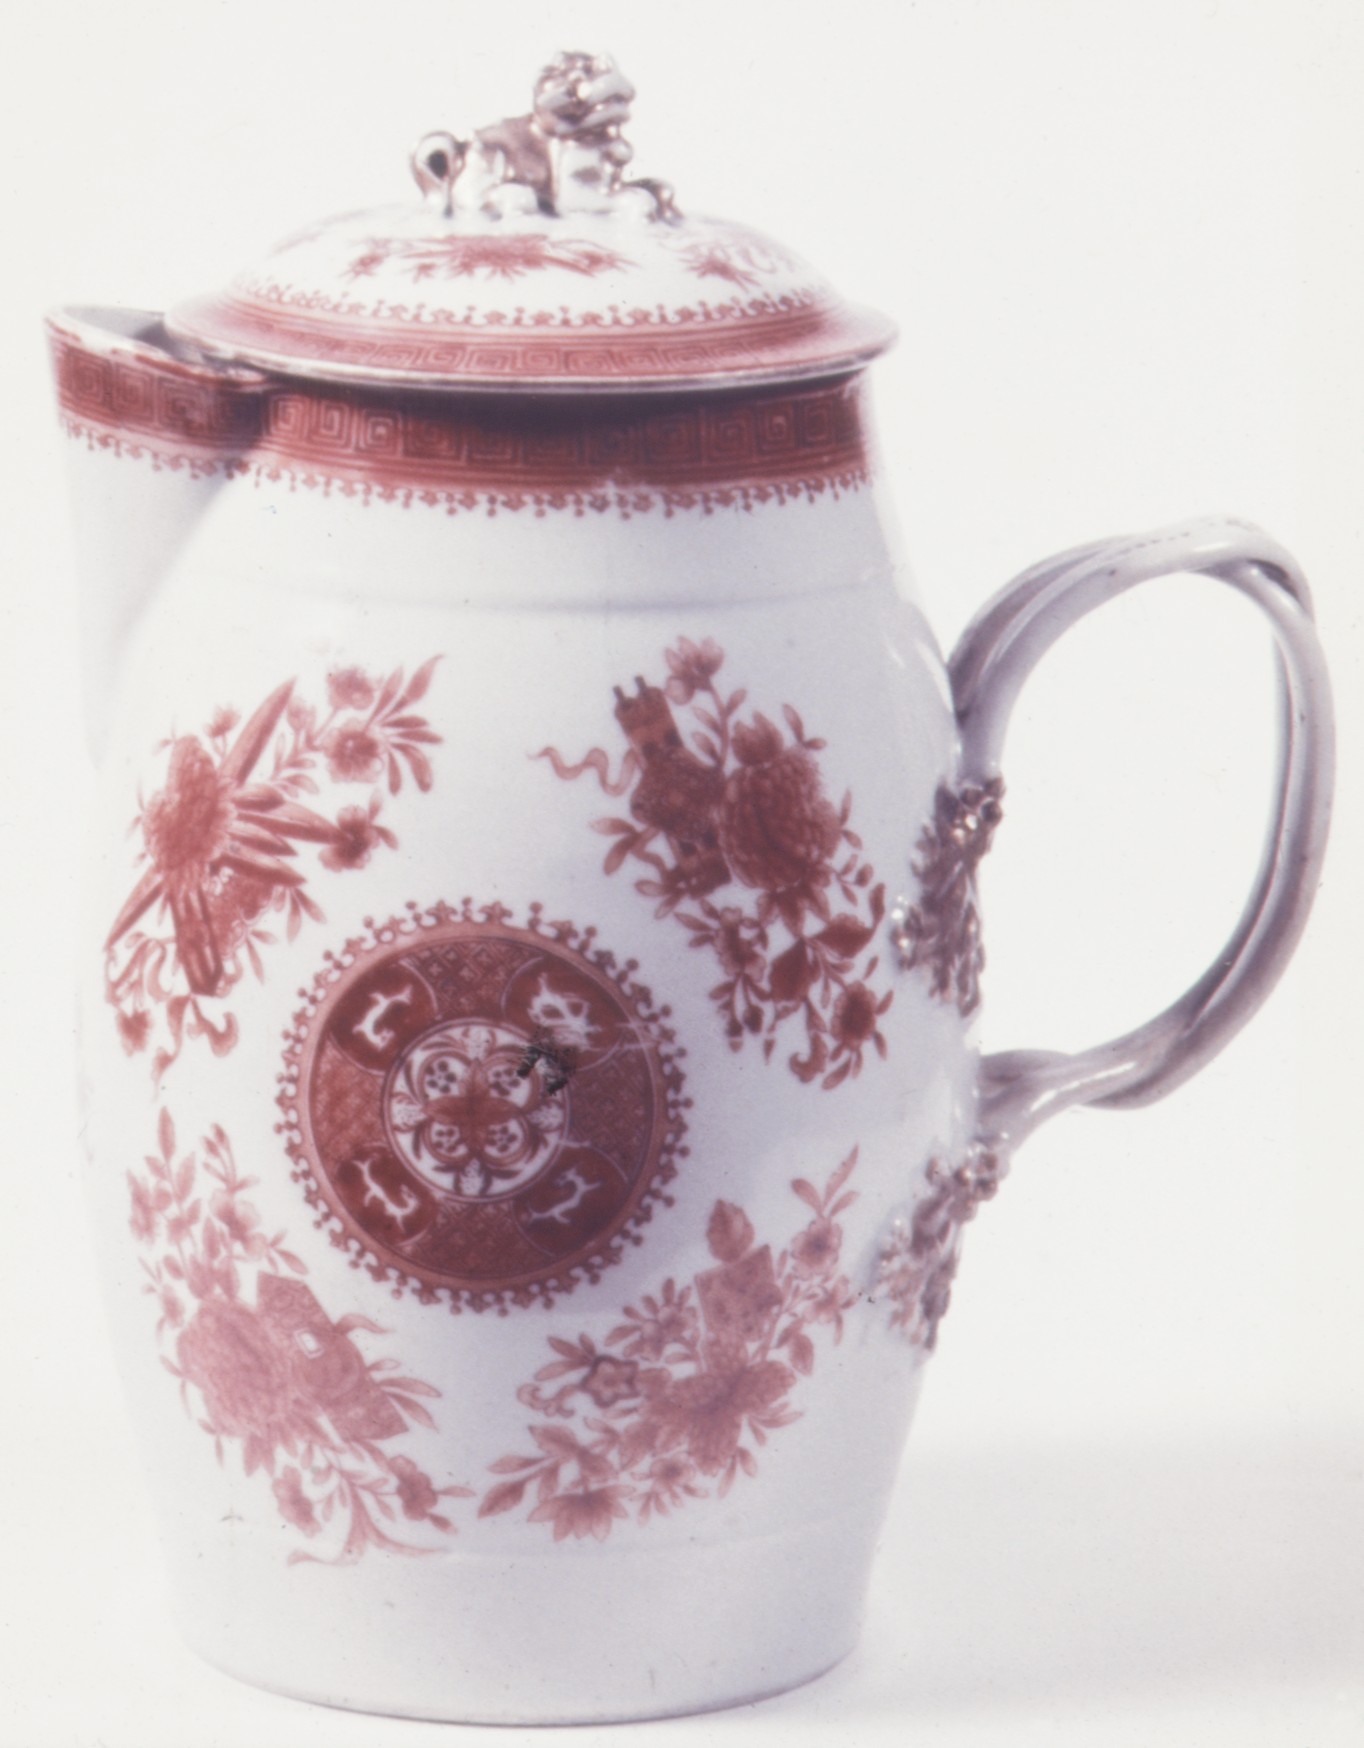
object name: flagon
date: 1801-1833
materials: hard paste porcelain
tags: flowers